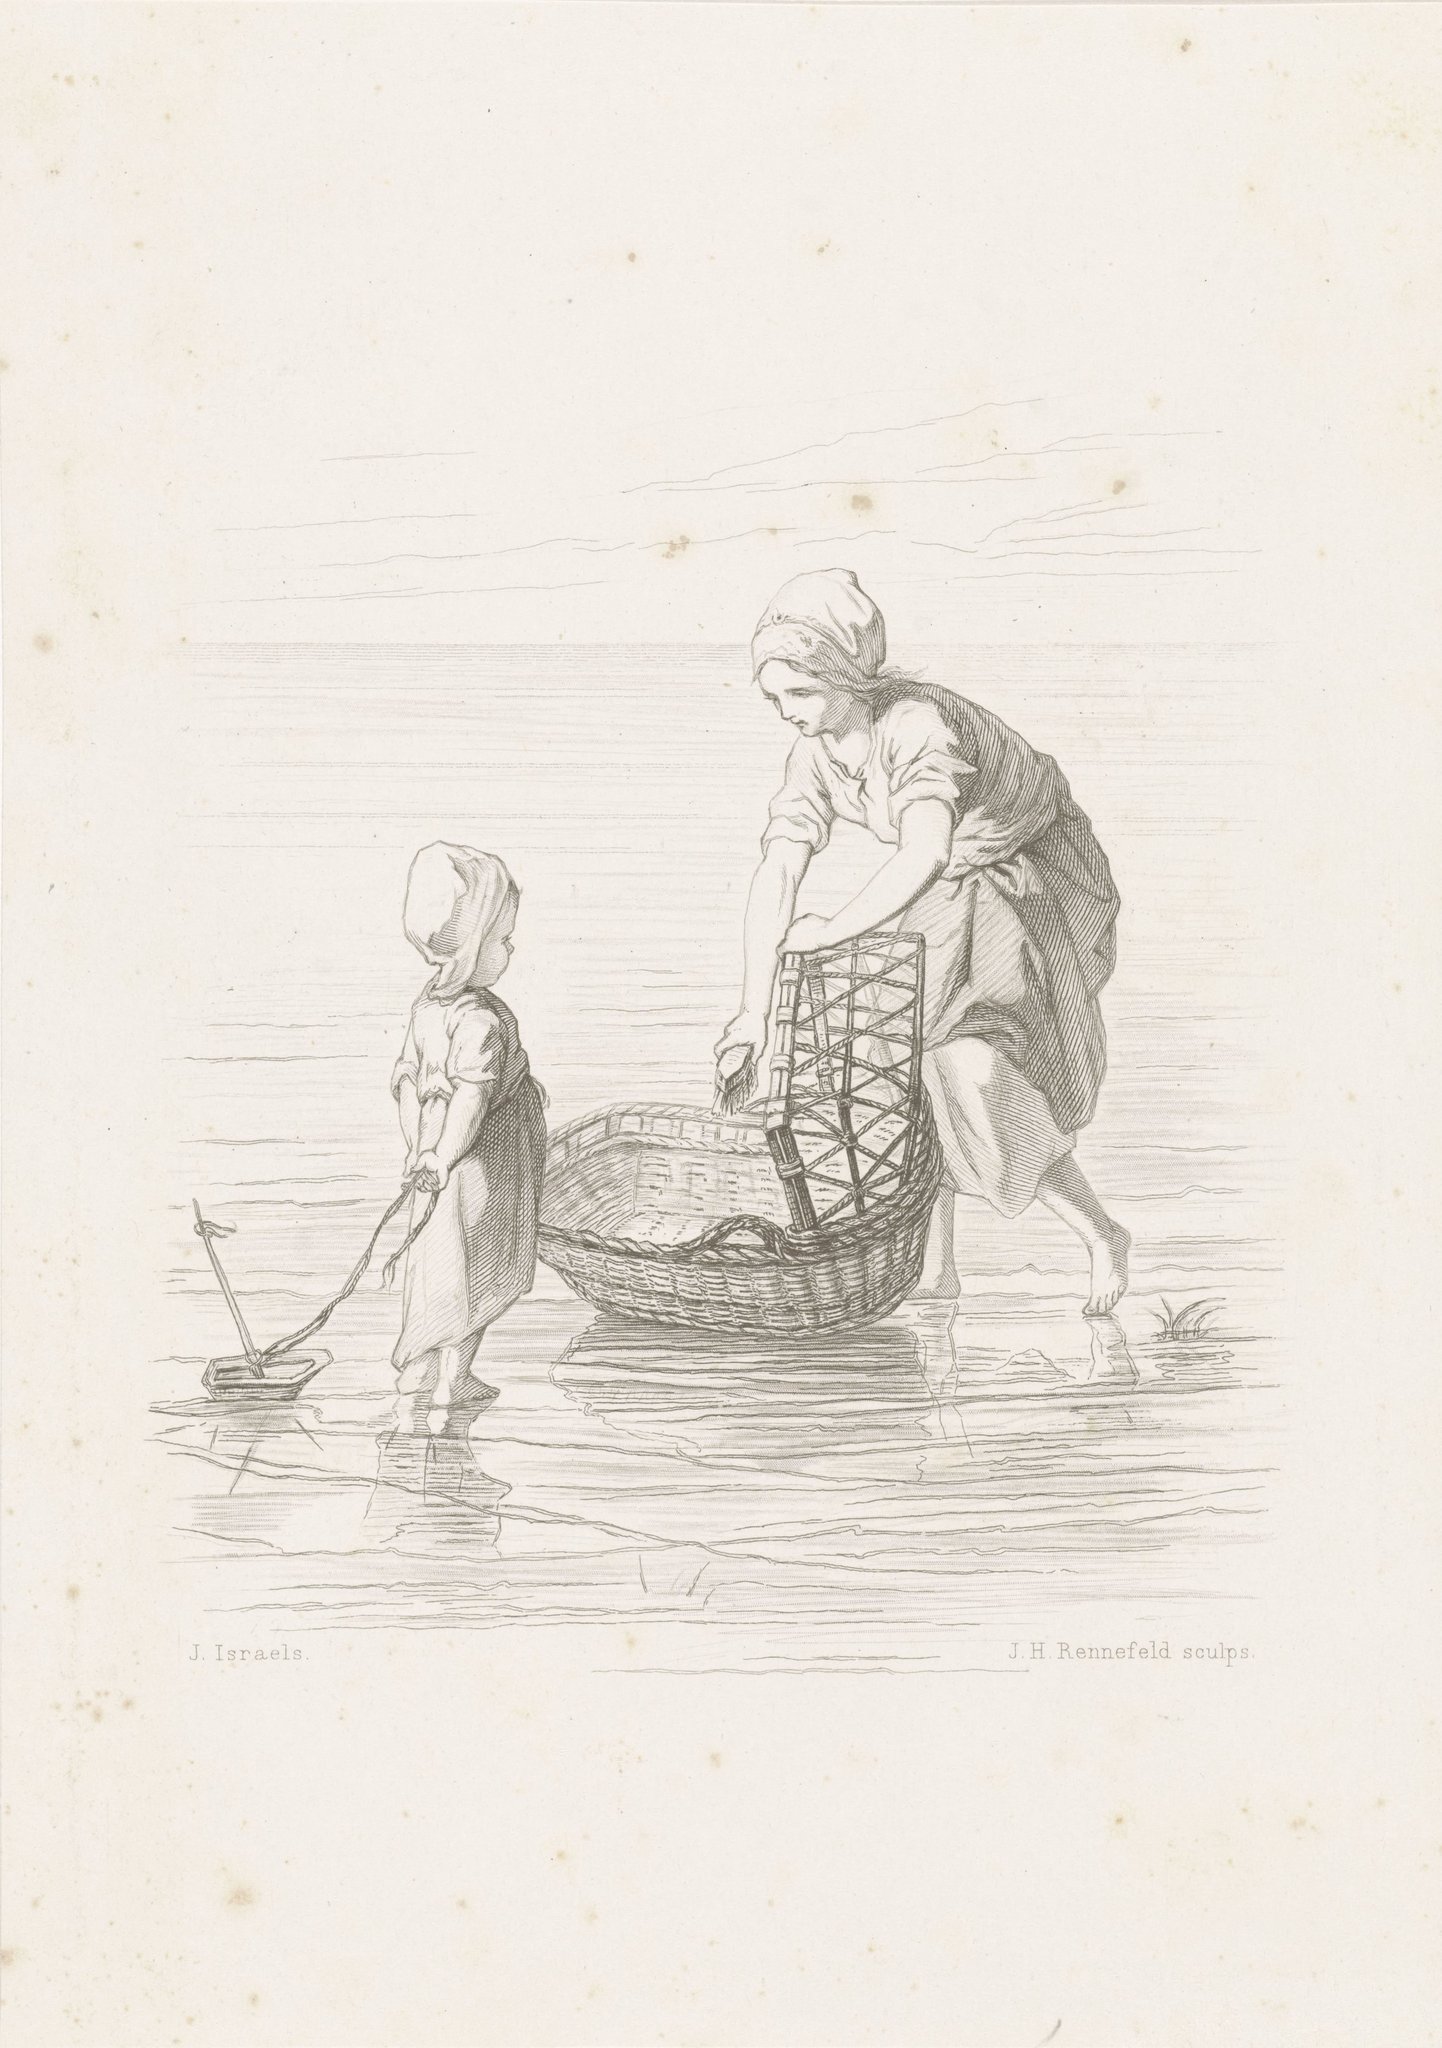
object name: print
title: De kinderen der zee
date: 1861-1872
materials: paper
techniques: roulette, engraving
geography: amsterdam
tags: cradle, crib, mother and child(ren), woman and child(ren) (family group), in or beside the water (on the beach)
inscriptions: collector's mark: Lugt 2228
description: Een jonge vrouw en een klein meisje staan aan de vloedlijn. De vrouw maakt een wieg schoon. Het kind heeft een touw vast met daaraan een bootje. De prent maakt deel uit van de serie prenten 'De kinderen der zee'.